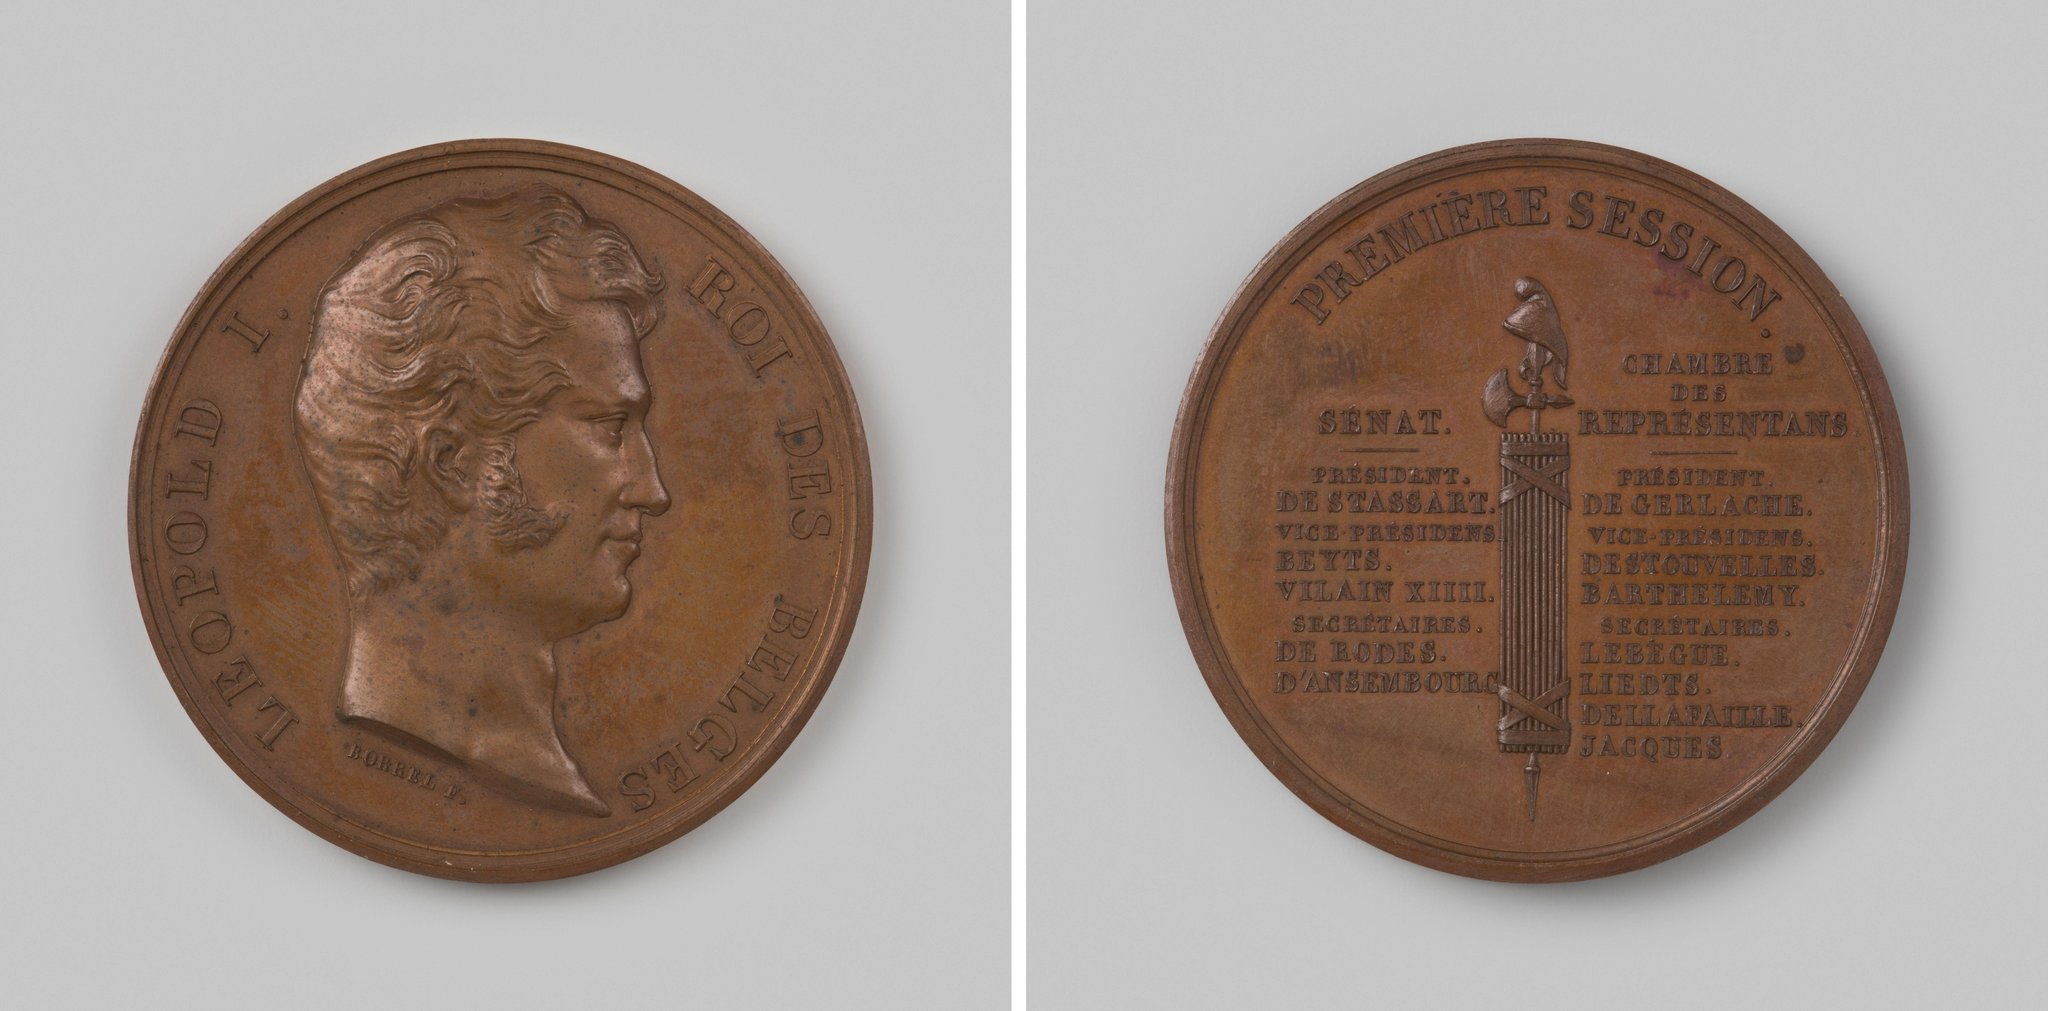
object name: history medal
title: Eerste zitting van de volksvertegenwoordiging, ter ere van Leopold I, koning der Belgen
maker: m. borrel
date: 1831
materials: bronze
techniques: striking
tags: laeken, leopold i (koning der belgen), earl, ghent, politician, brussels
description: Bronzen penning. Voorzijde: borststuk man binnen omschrift. Keerzijde: roedebundel met bijl, bekroond metvrijheidsmuts temidden van opschriften binnen omschrift